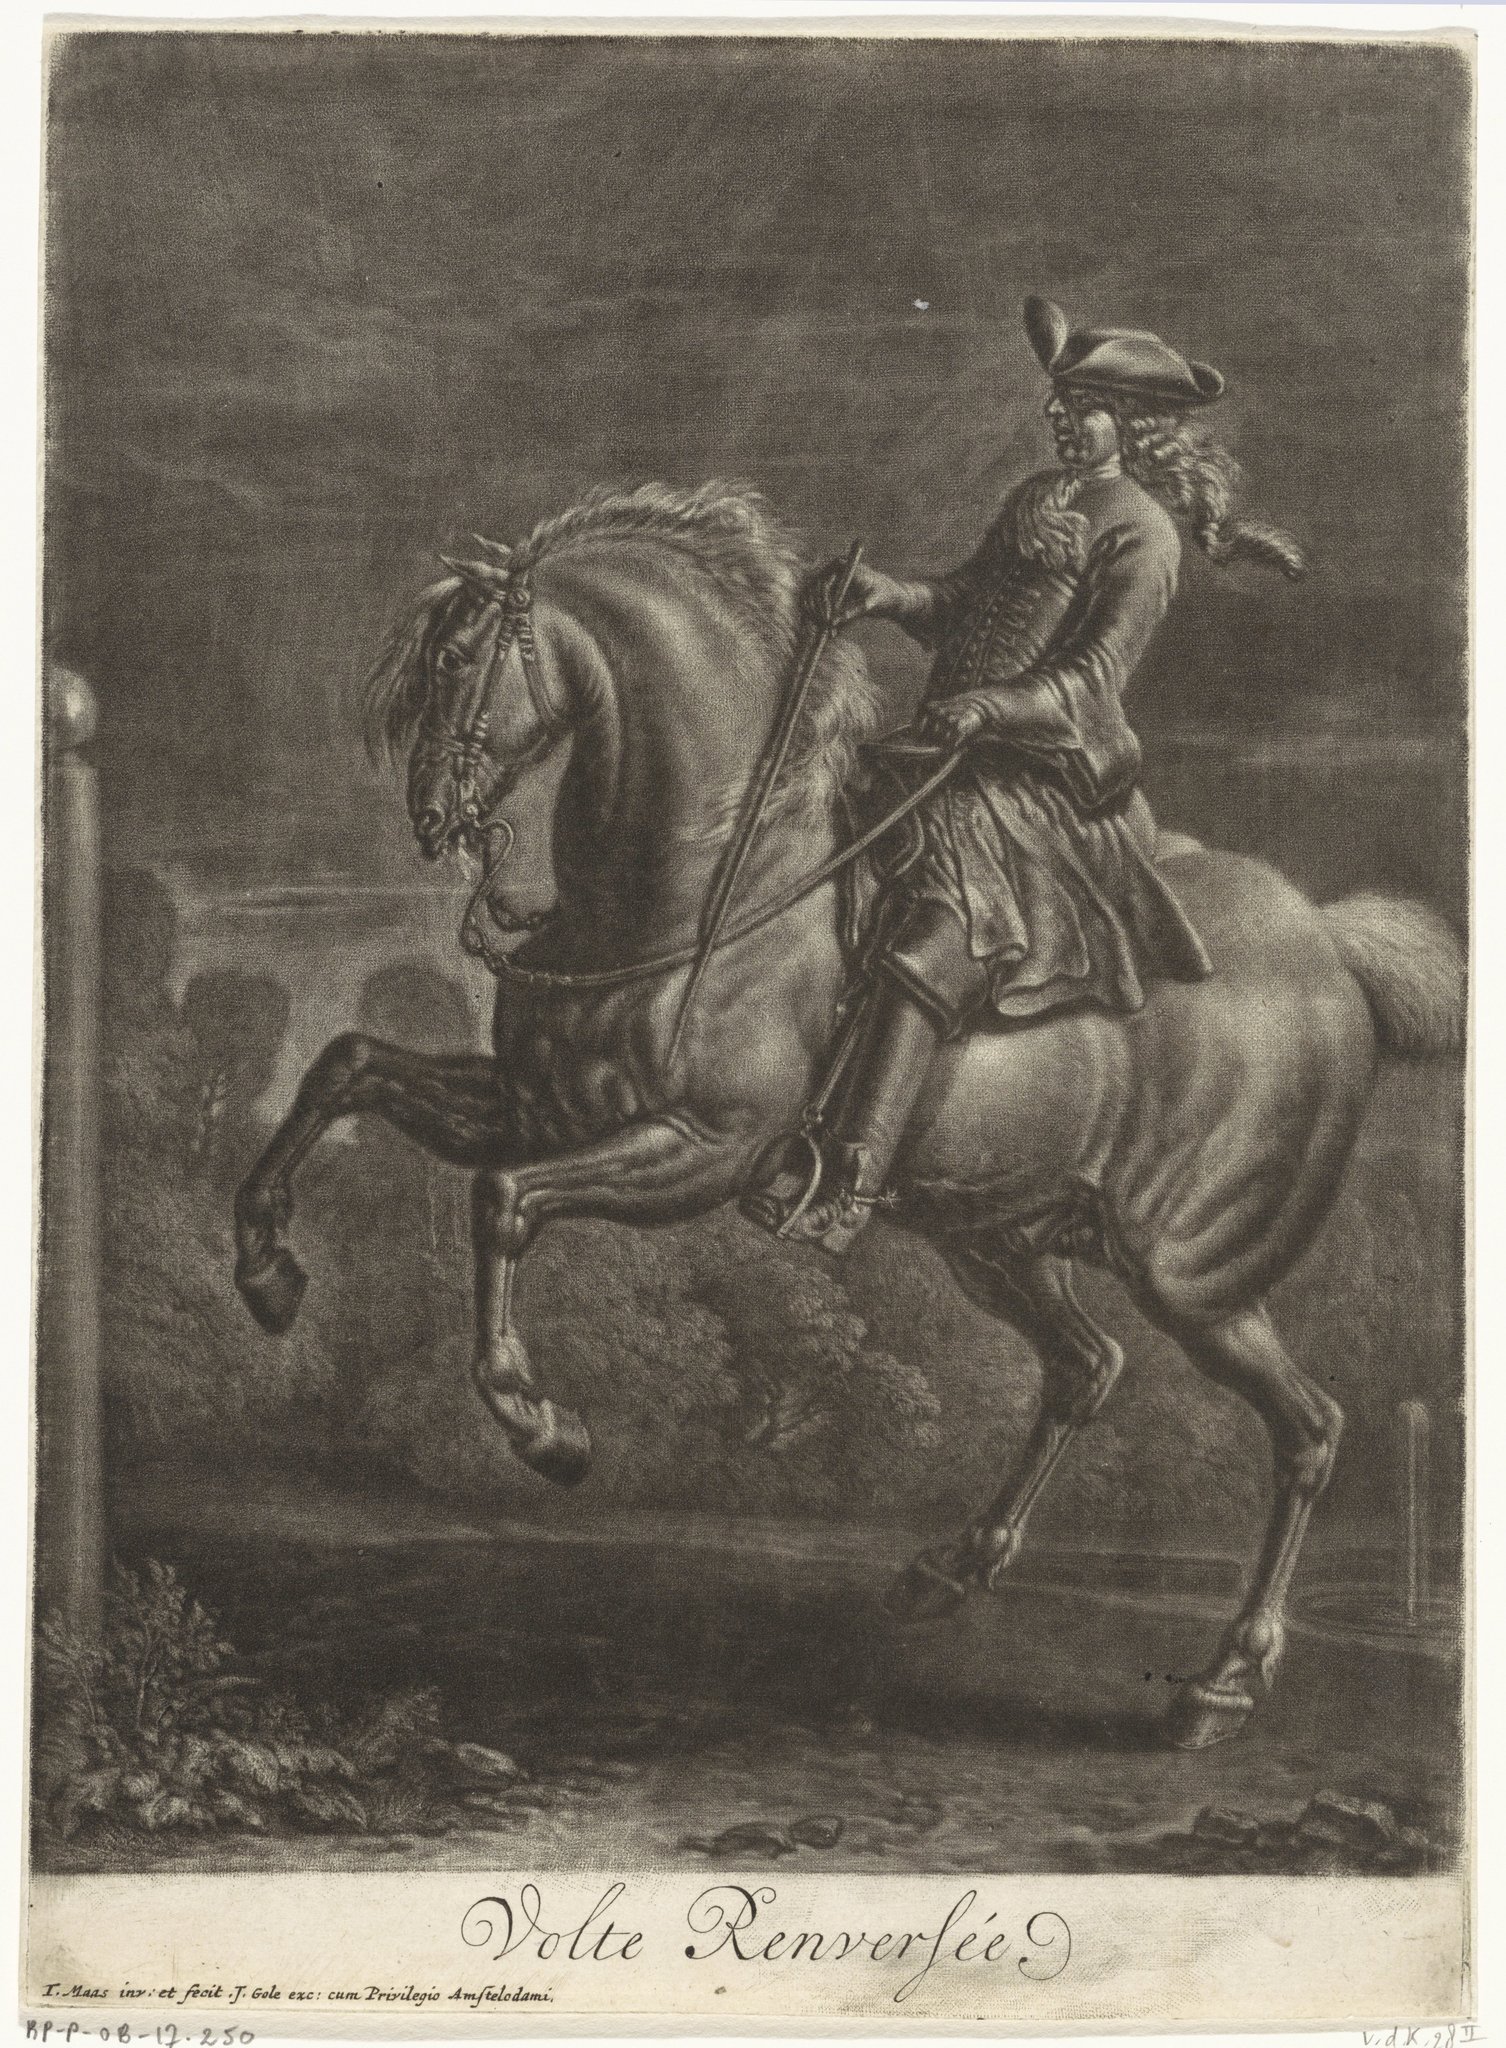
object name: print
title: Steigerend paard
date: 1675-1724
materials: paper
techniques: engraving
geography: amsterdam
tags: training of horses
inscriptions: collector's mark: Lugt 240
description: Een man doet een dressuurproef met een paard. Het dier steigert naar links.